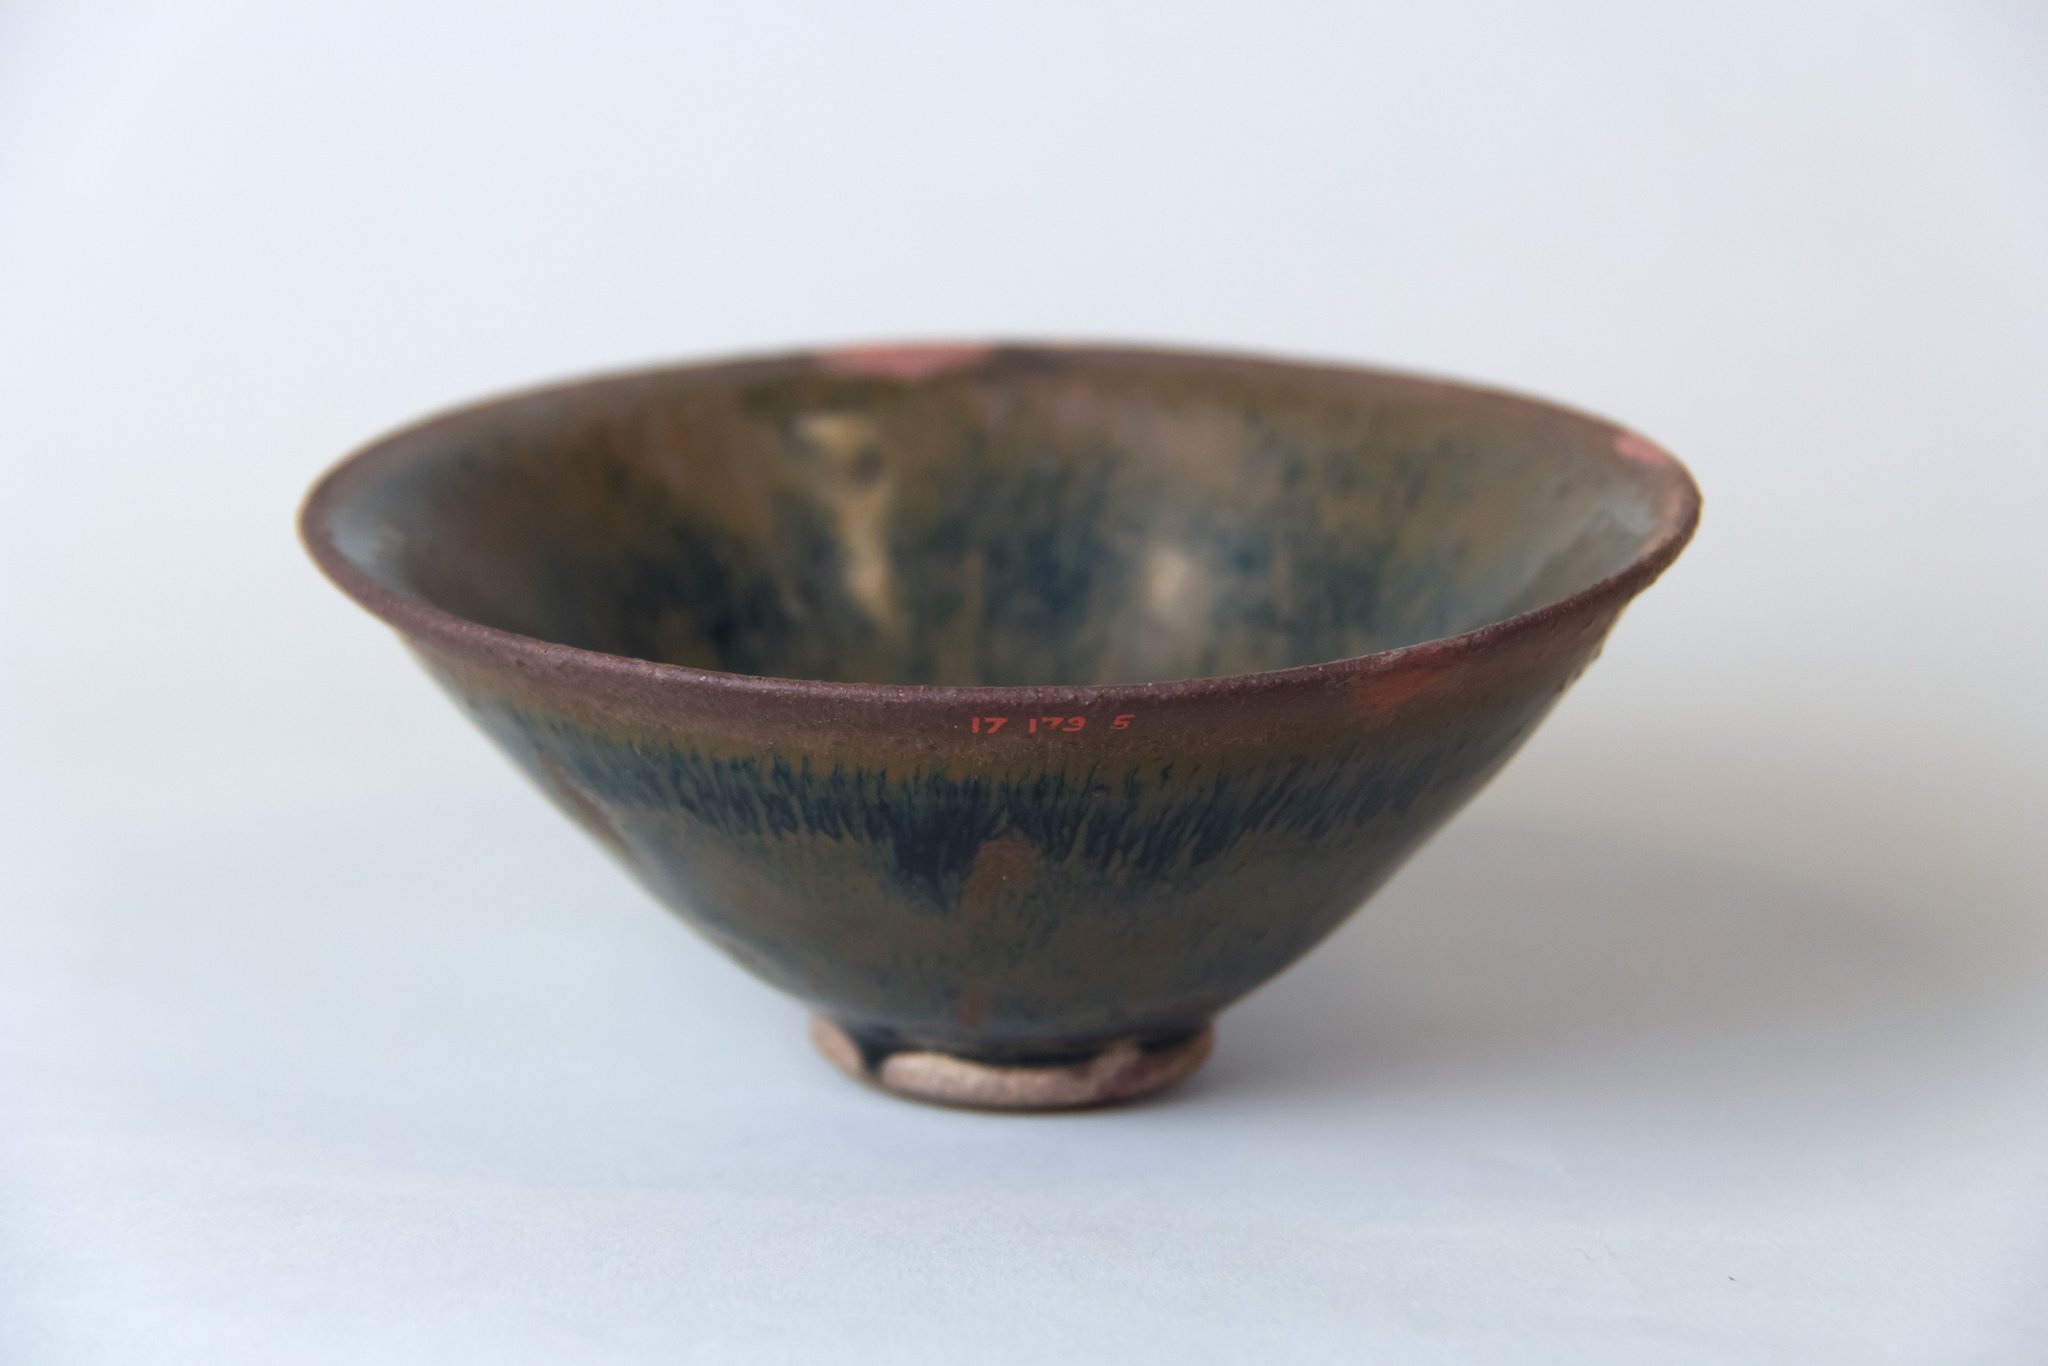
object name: teabowl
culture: chinese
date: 1127-1279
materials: glaze, stoneware